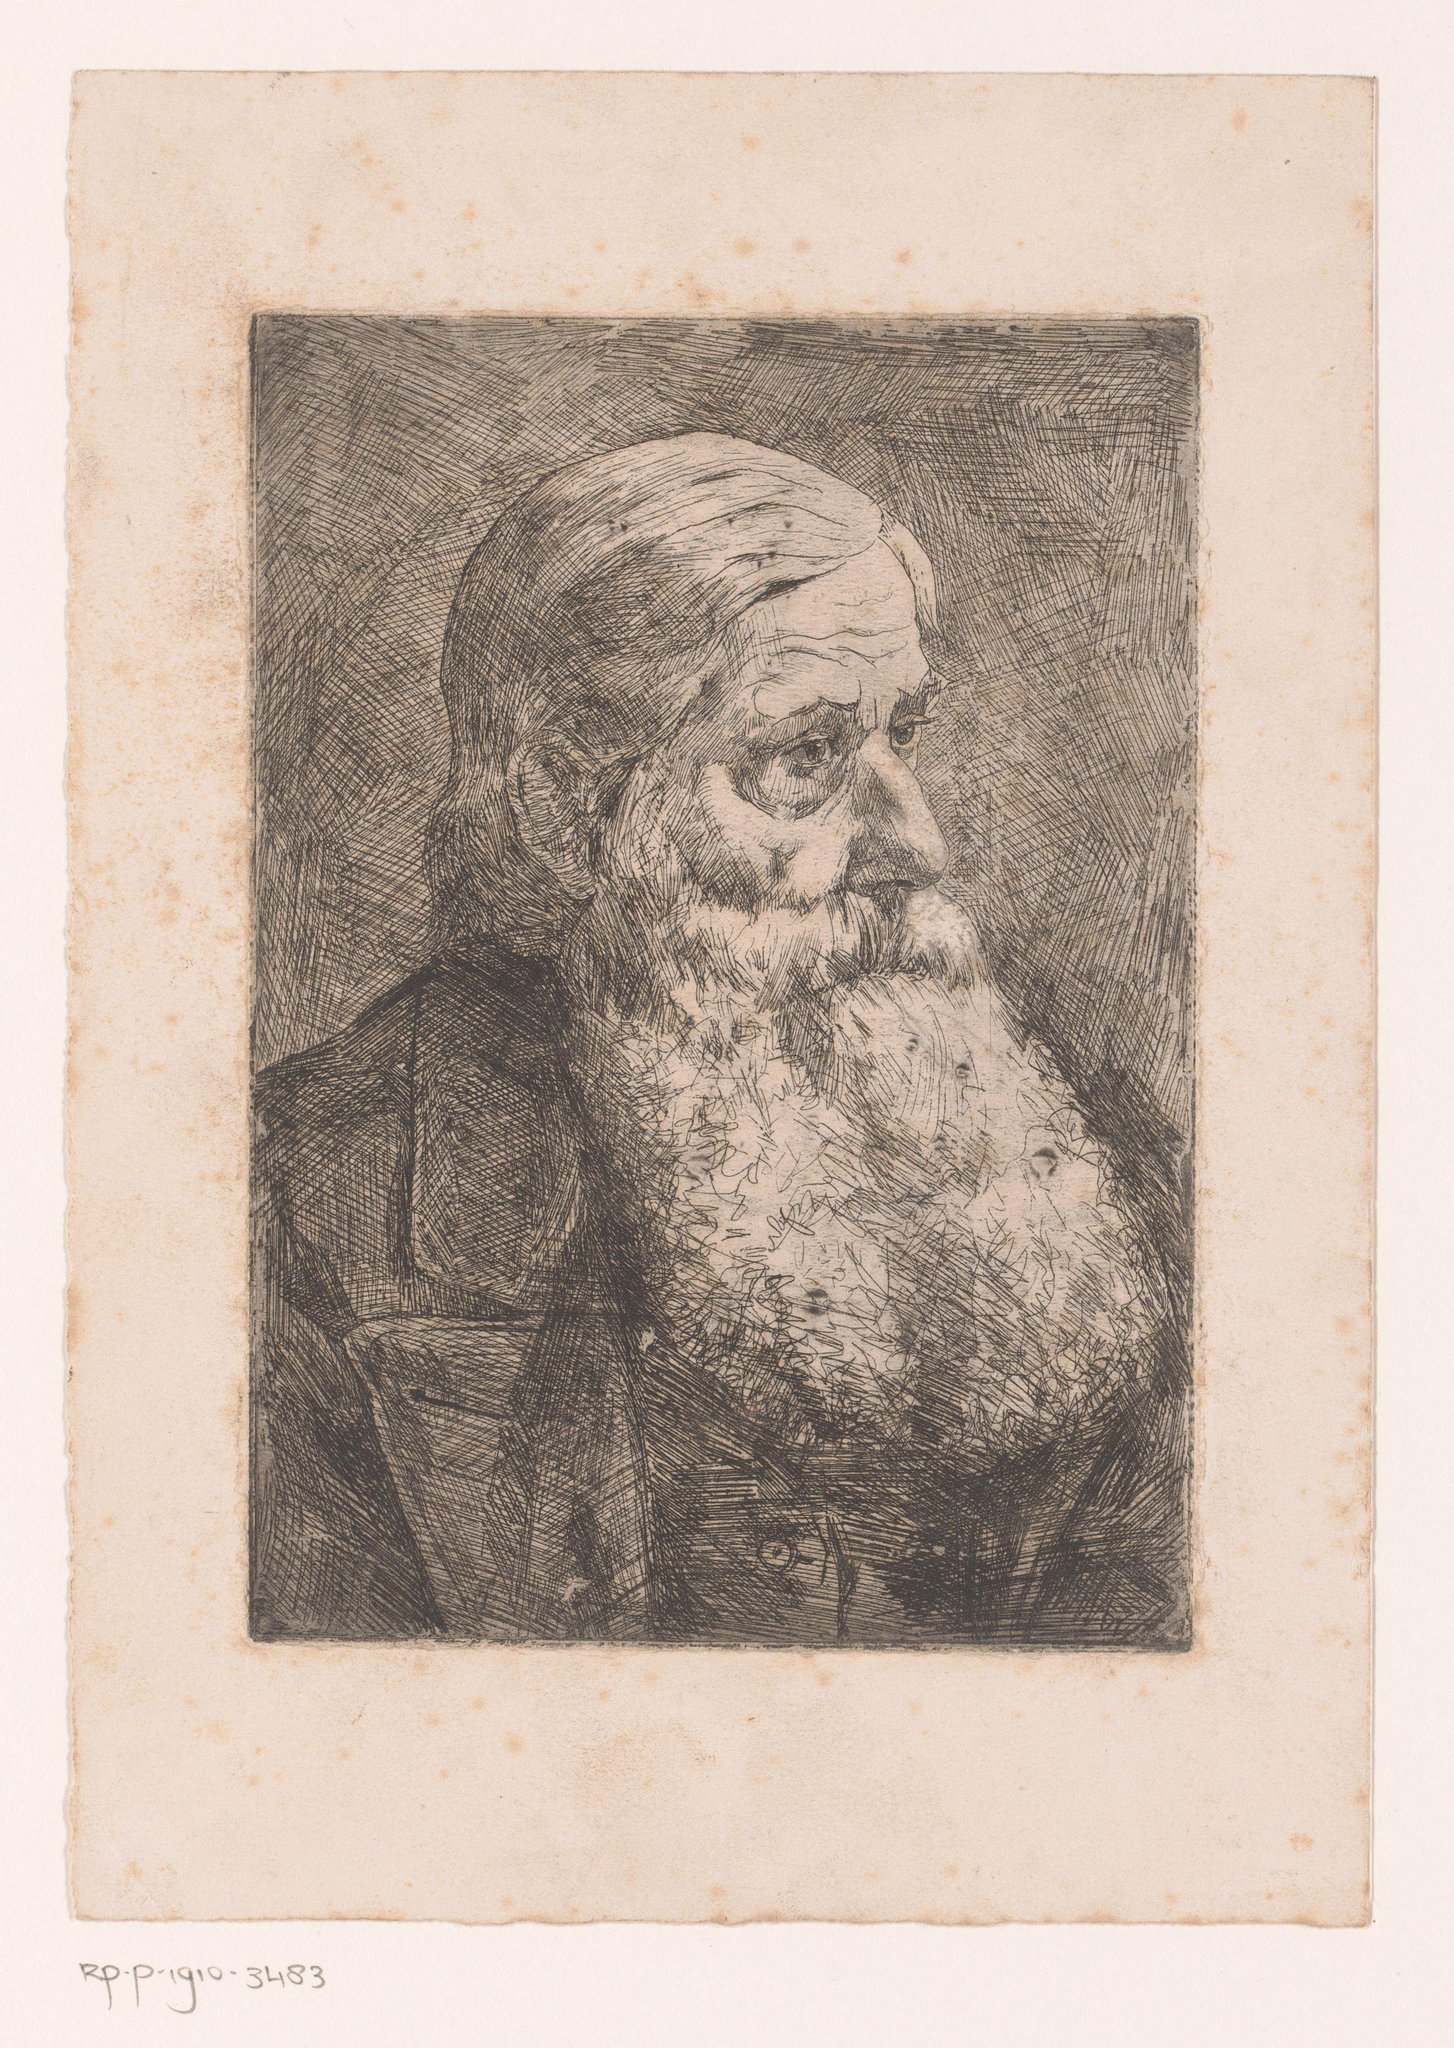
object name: print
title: Portret van een onbekende man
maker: henri de graer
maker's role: painter, print maker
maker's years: 1856-1915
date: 1883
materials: paper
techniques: etching, intaglio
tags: anonymous historical person portrayed alone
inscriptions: collector's mark: Lugt 2228